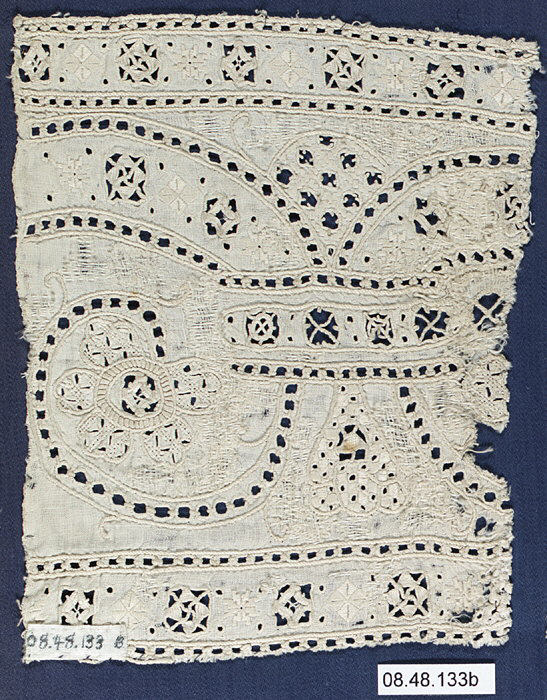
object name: fragment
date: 1567-1600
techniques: embroidery